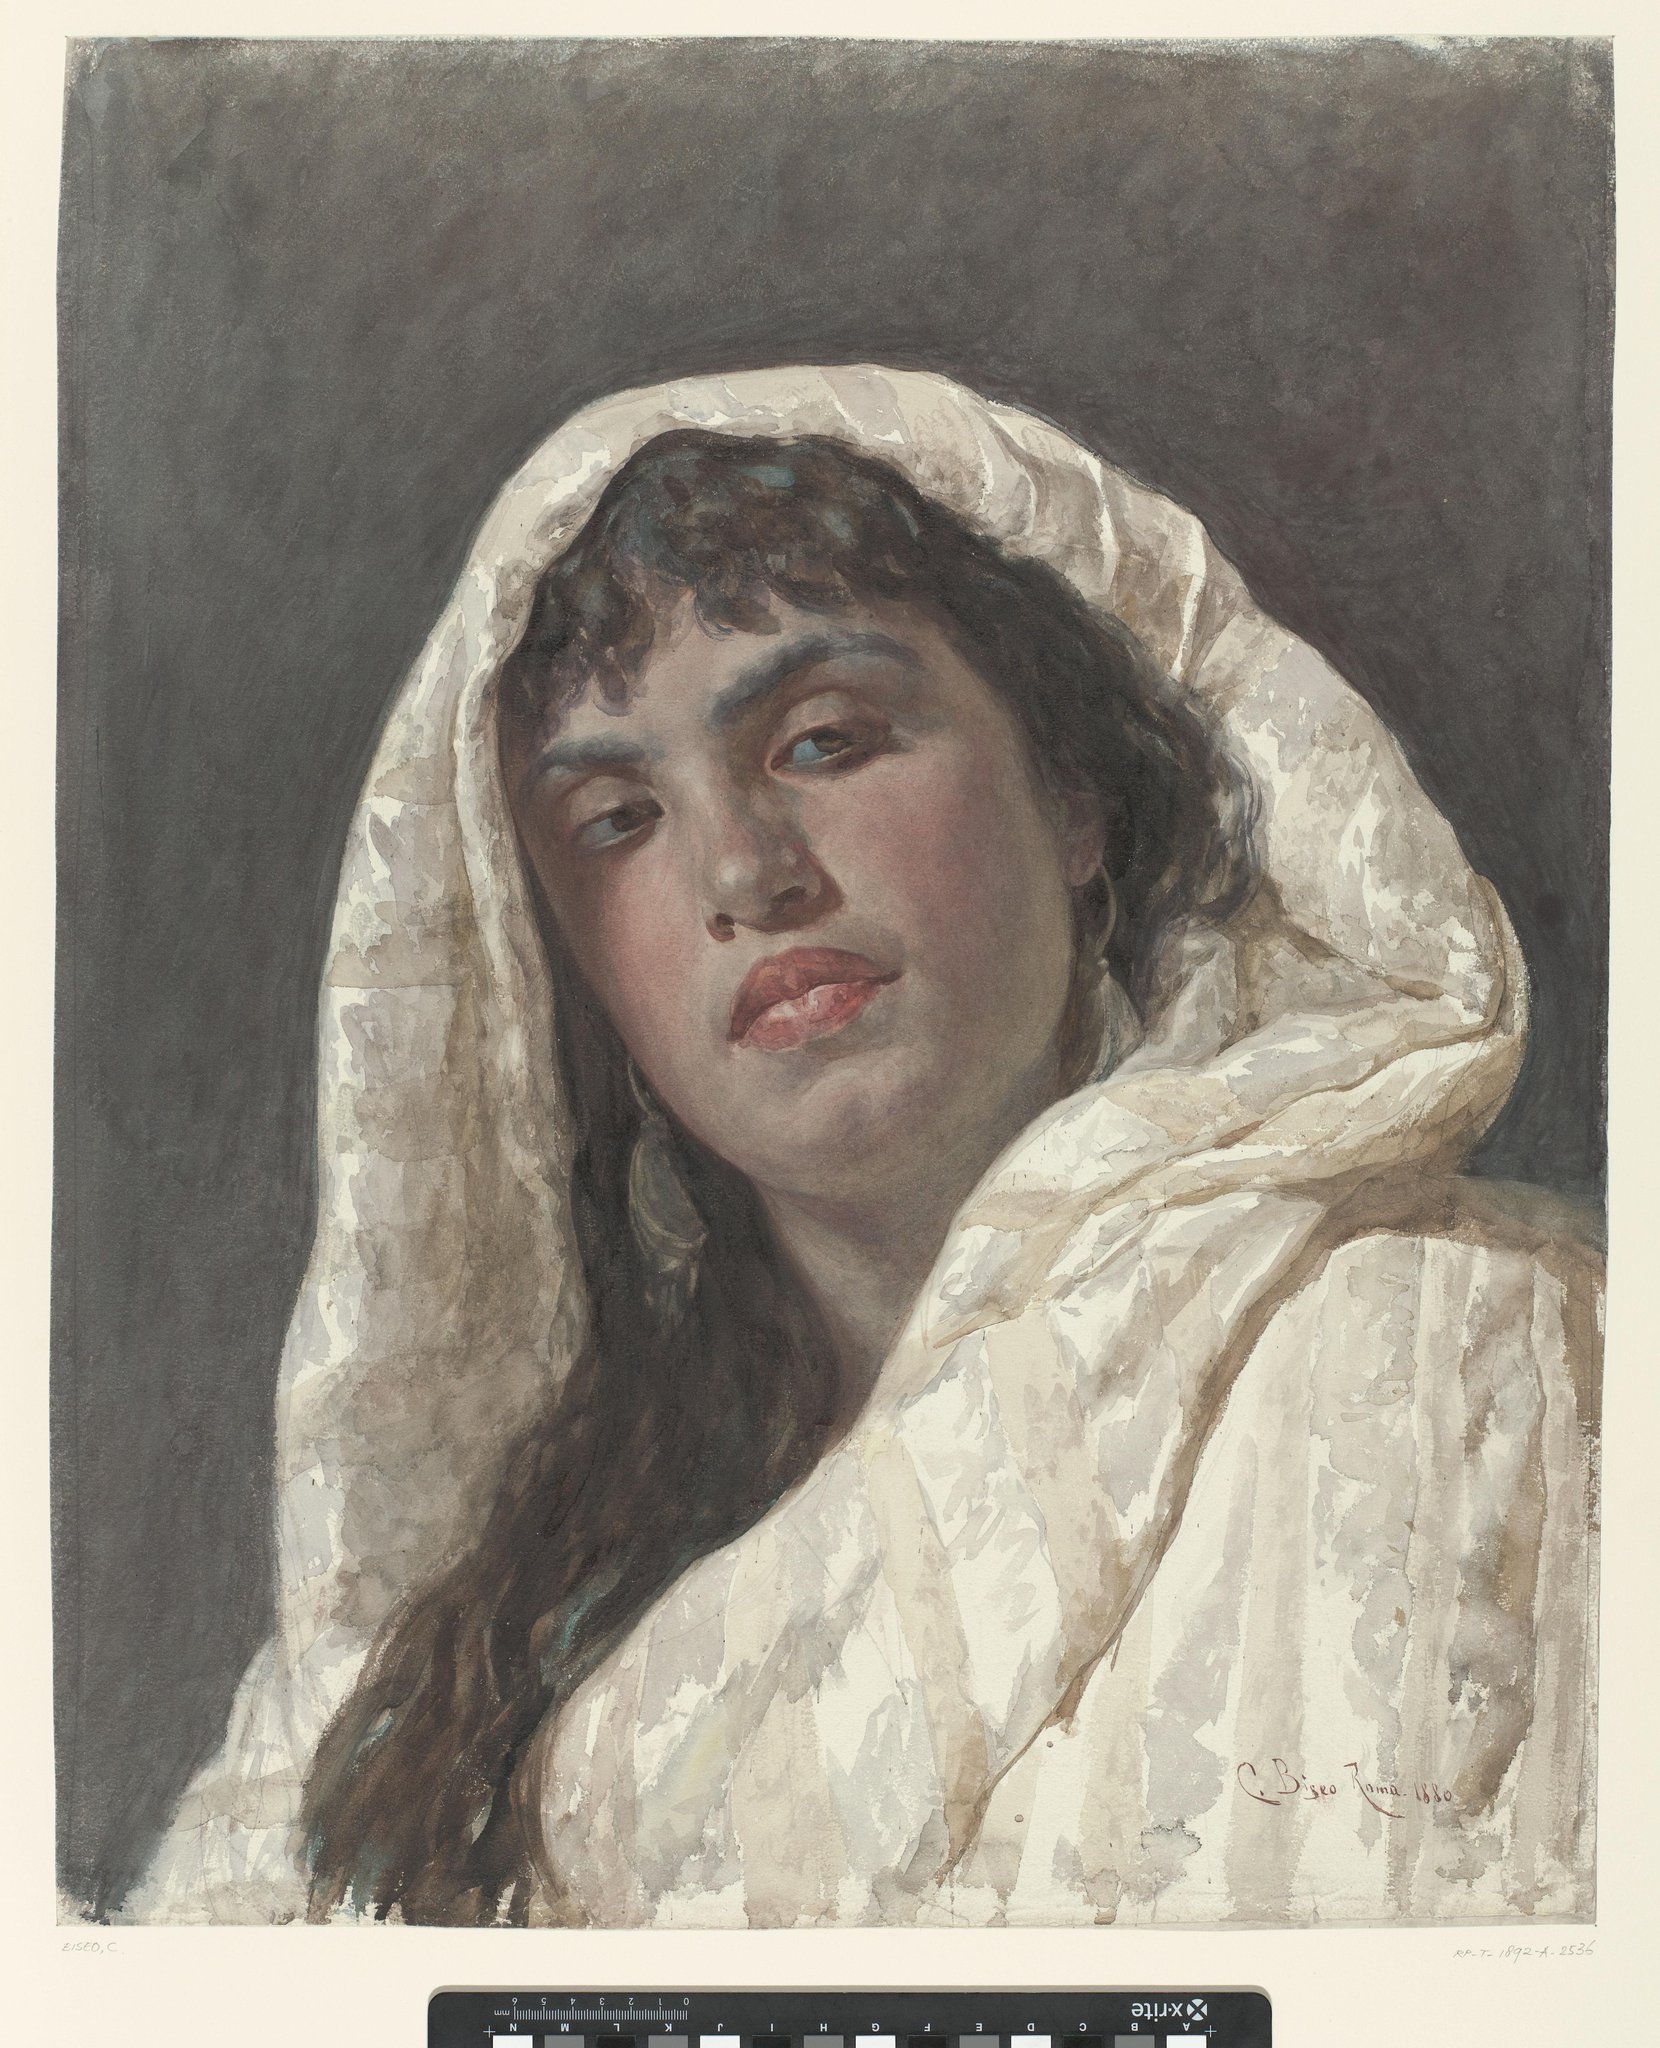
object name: drawing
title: Buste van een Oosterse vrouw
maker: cesare biseo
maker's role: draughtsman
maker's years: 1843-1909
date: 1880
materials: paper, pencil, watercolor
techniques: brush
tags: asiatic races and peoples (+ women)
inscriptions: date: ‘1880’